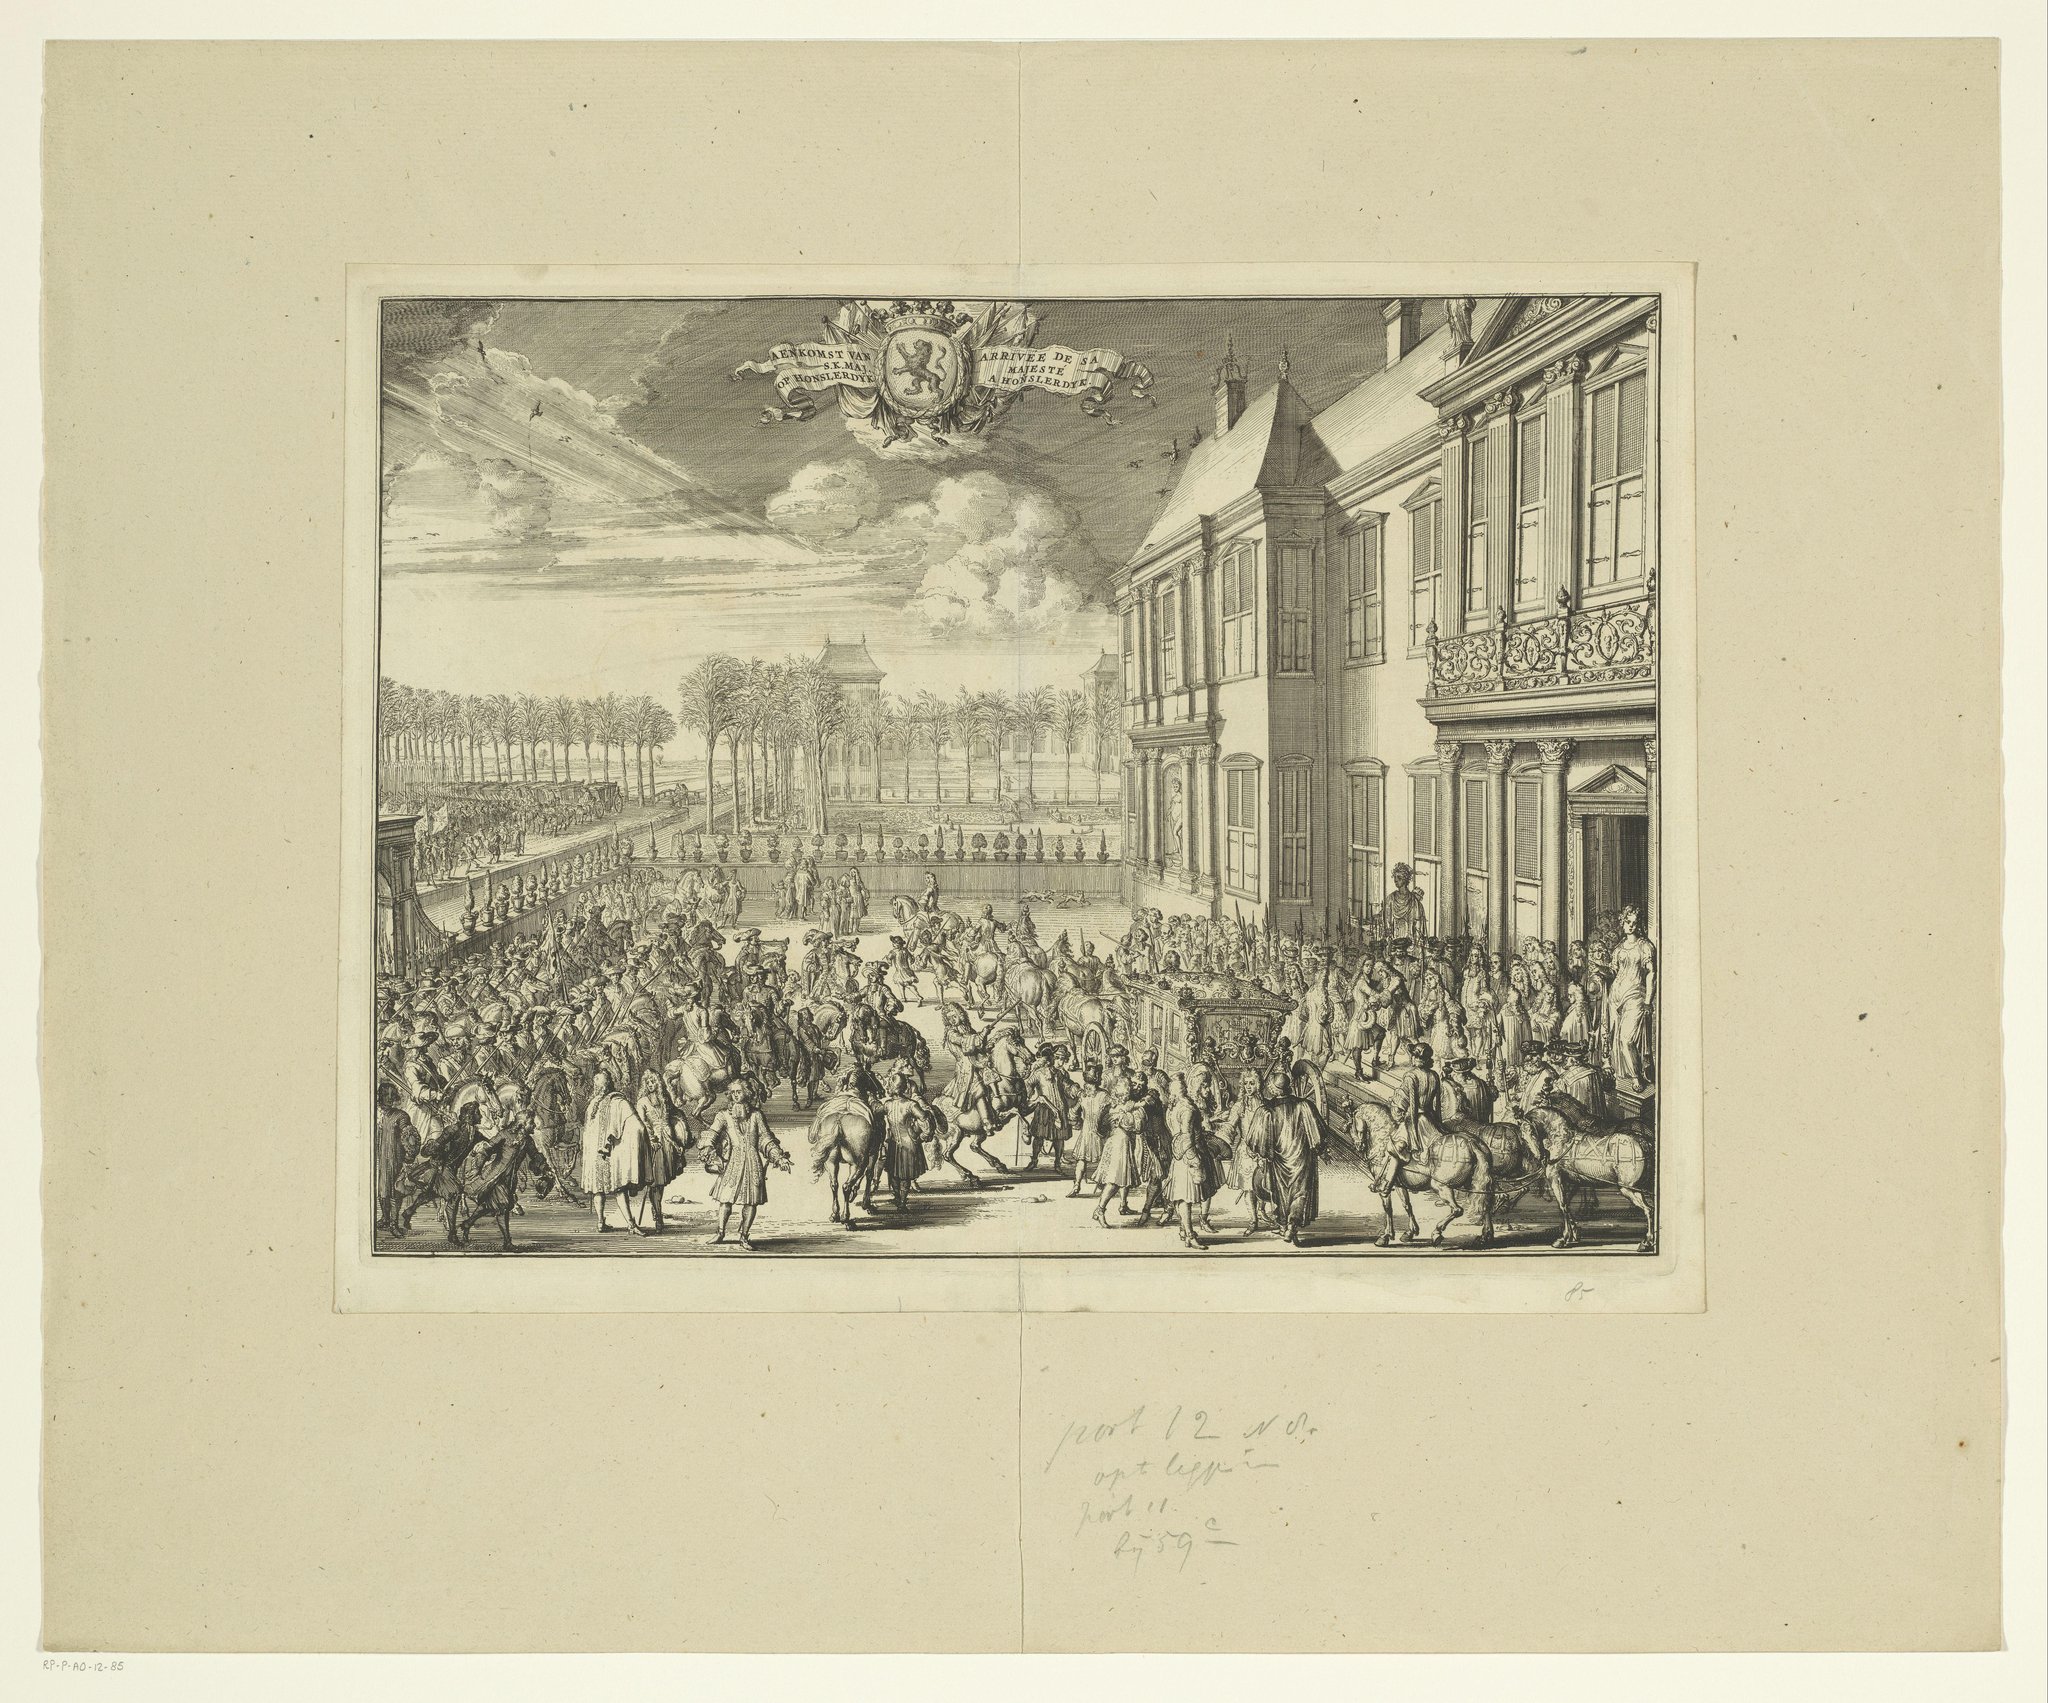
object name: book illustration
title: Aankomst van Willem III op Paleis Honselaarsdijk, 1691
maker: romeyn de hooghe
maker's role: draughtsman, goldsmith, painter, print maker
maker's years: 1645-1708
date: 1691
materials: paper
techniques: etching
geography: northern netherlands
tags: the hague, william iii (prince of orange and king of england, scotland, and ireland)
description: Prent ook gebruikt in: Bidloo, Govard. Komste van zyne majesteit Willem III. Koning van Groot Britanje, enz. in Holland; ofte omstandelyke beschryving van alles, (…) vercierd met kopere plaaten. Den Haag: Arnoud Leers, 1691.